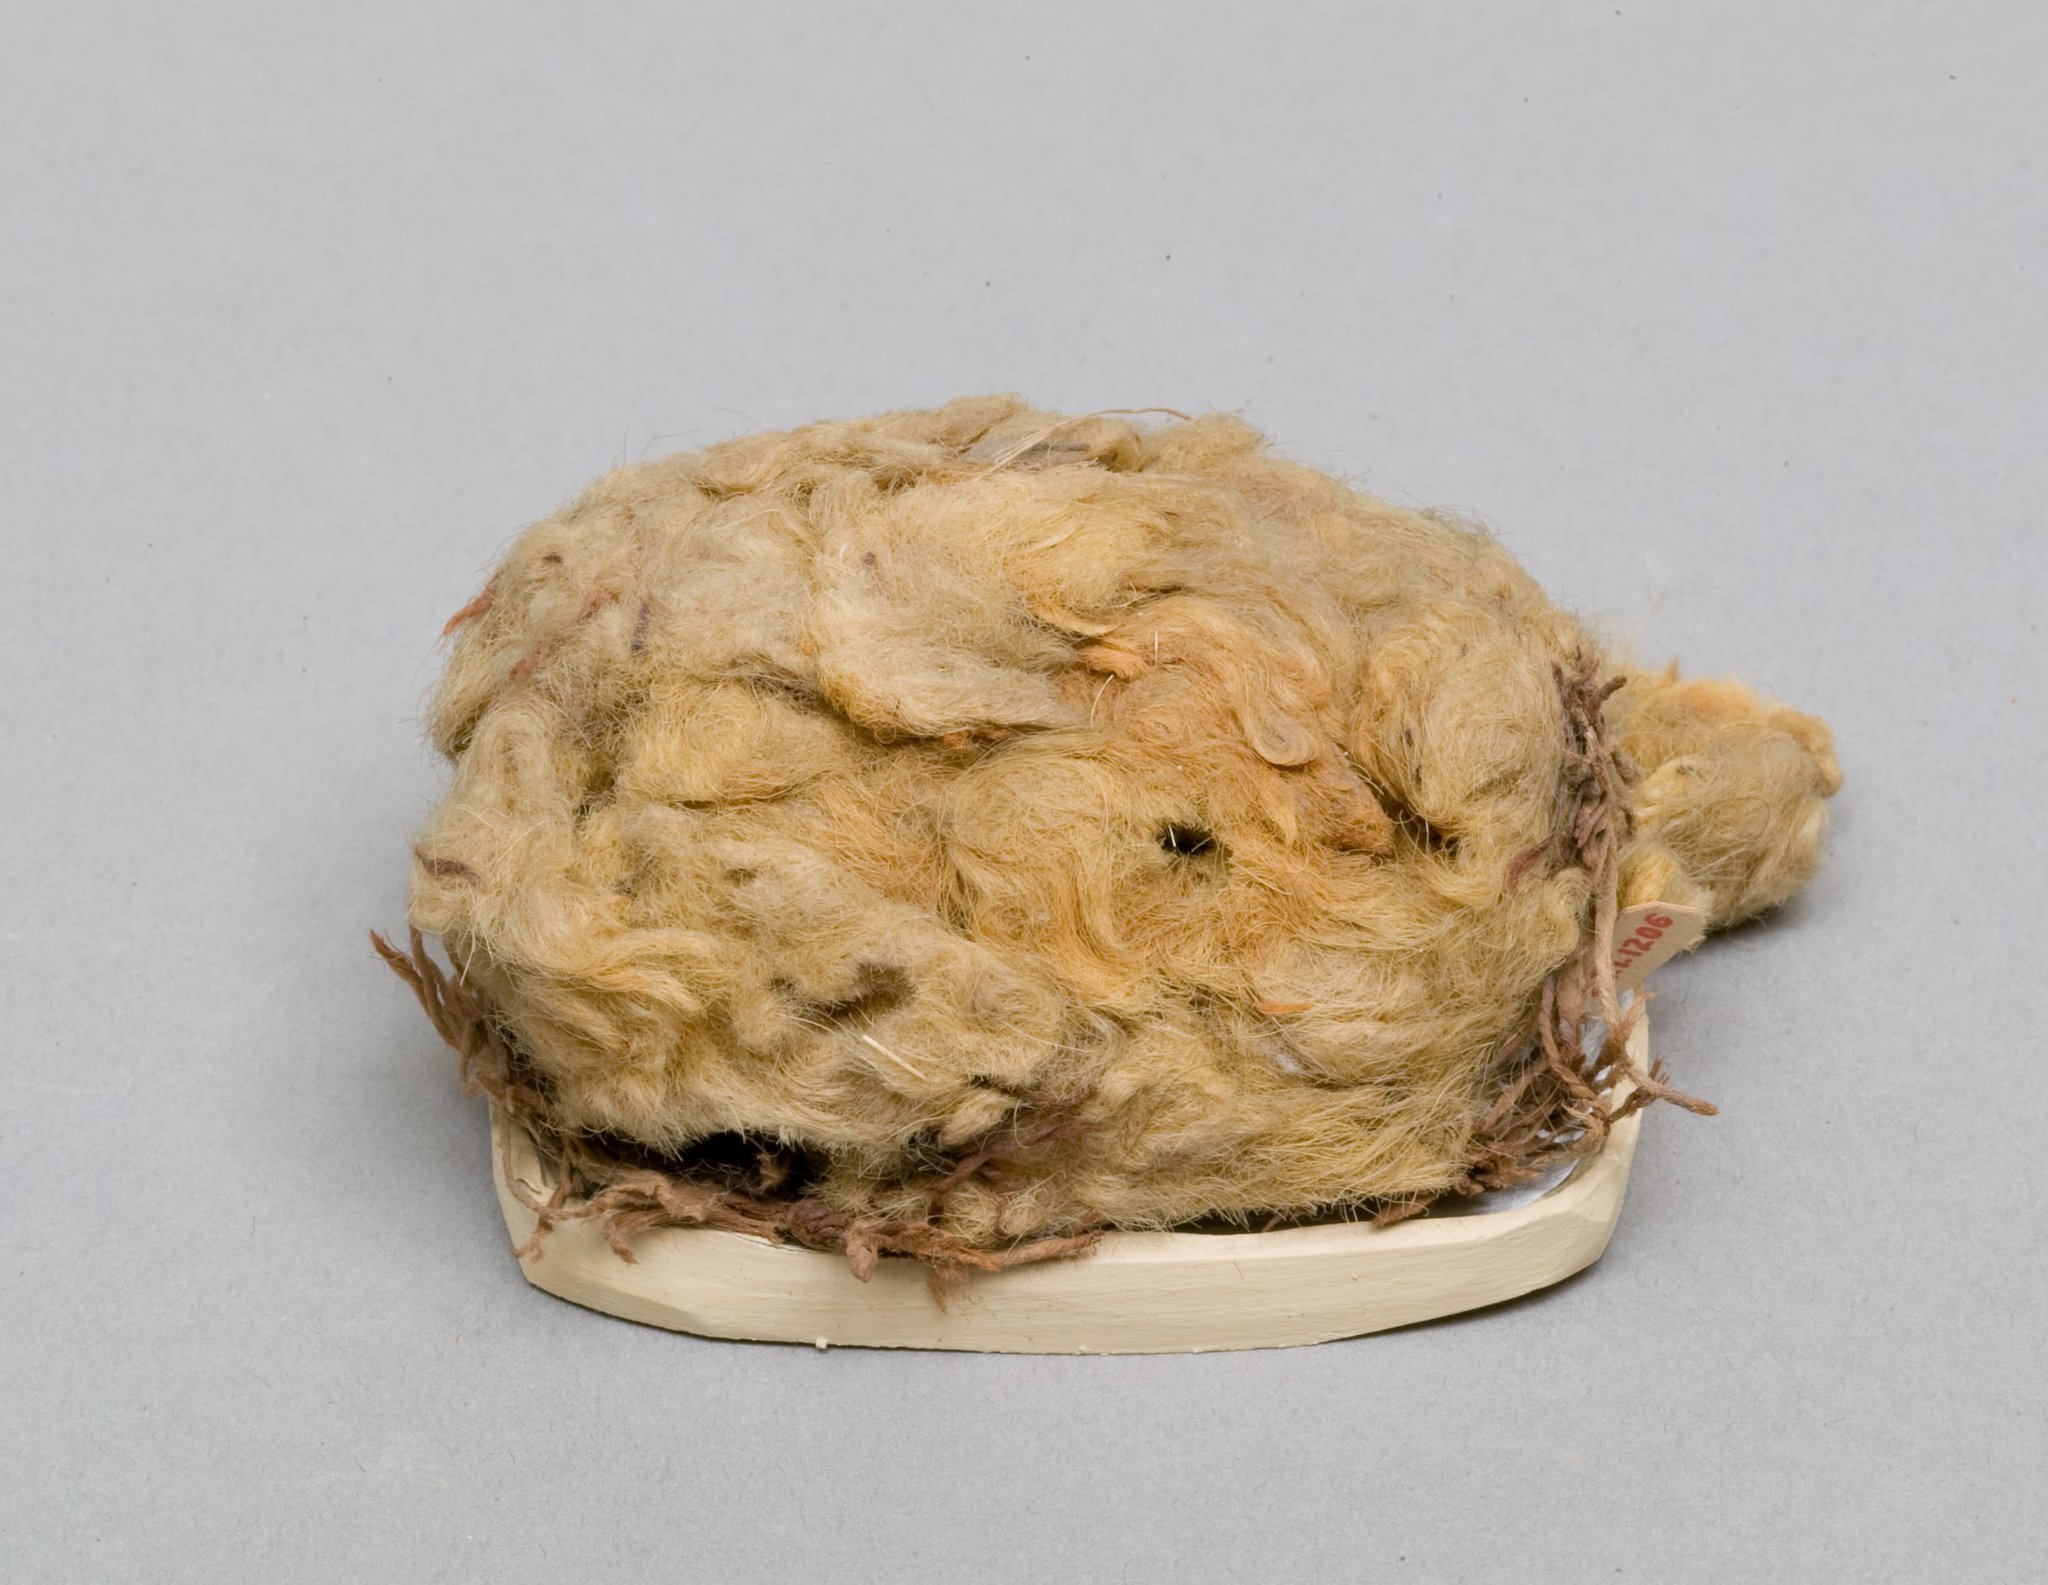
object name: linen, wool thread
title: Ball of wool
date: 1295-1070 BCE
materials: linen, wool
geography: egypt